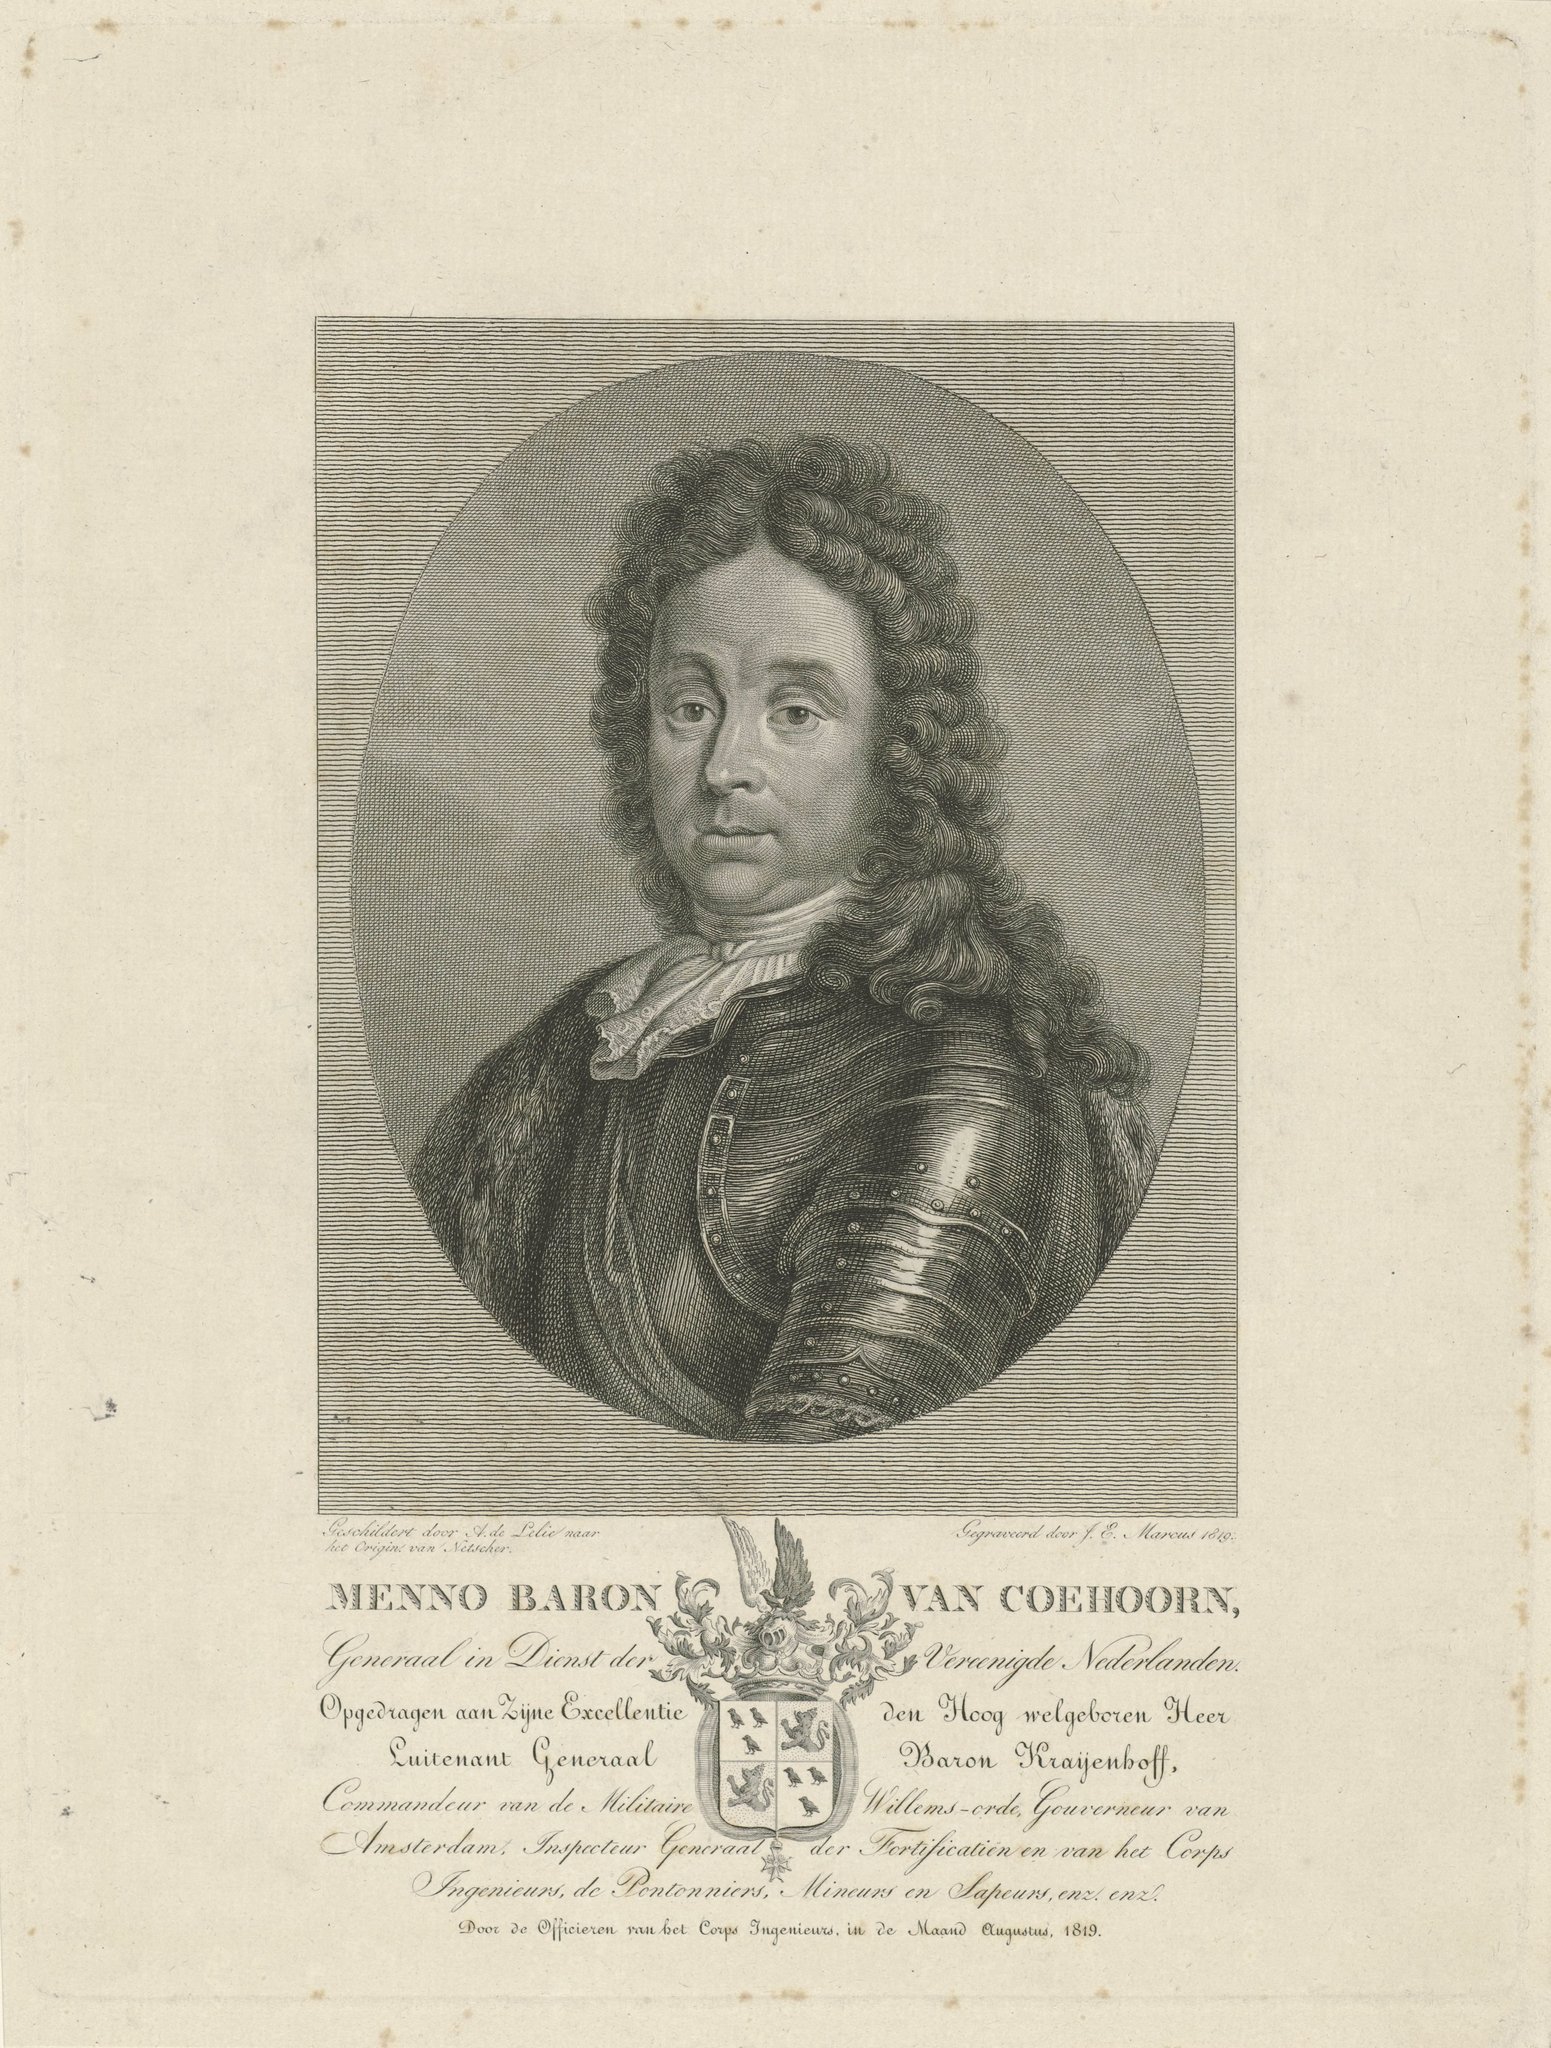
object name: print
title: Portret van Menno baron van Coehoorn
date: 1819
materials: paper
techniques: engraving, etching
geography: amsterdam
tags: nijmegen, physicist, cornelis rudolphus theodorus krayenhoff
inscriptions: collector's mark: Lugt 12, collector's mark: Lugt 2228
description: Portret van generaal Menno baron van Coehoorn, met onder het portret een tekst, waarin staat dat de prent wordt aangeboden door de officieren van het Corps Ingenieurs aan hun inspecteur genraal, Cornelis Rudolphus Theodorus Krayenhoff, wiens familiewapen is afgebeeld.